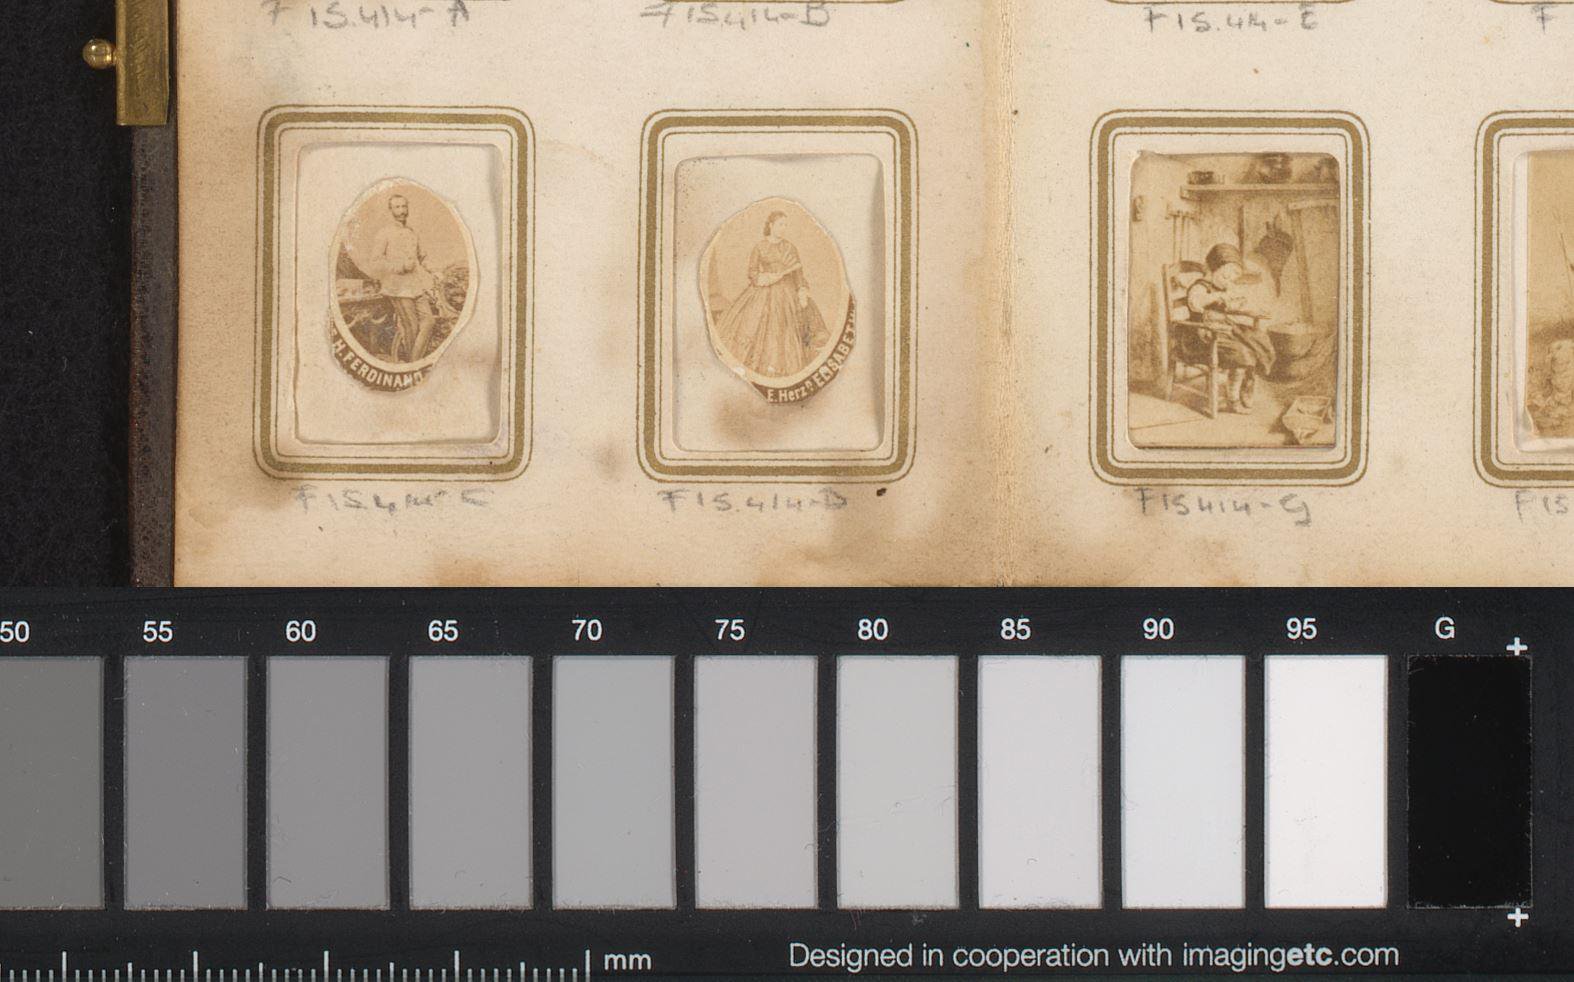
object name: photograph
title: Miniatuurportret van Elisabeth Marie van Oostenrijk, aartshertogin van Oostenrijk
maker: Anonymous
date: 1851-1900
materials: paper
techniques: albumen print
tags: vienna, nobility and patriciate; chivalry, knighthood